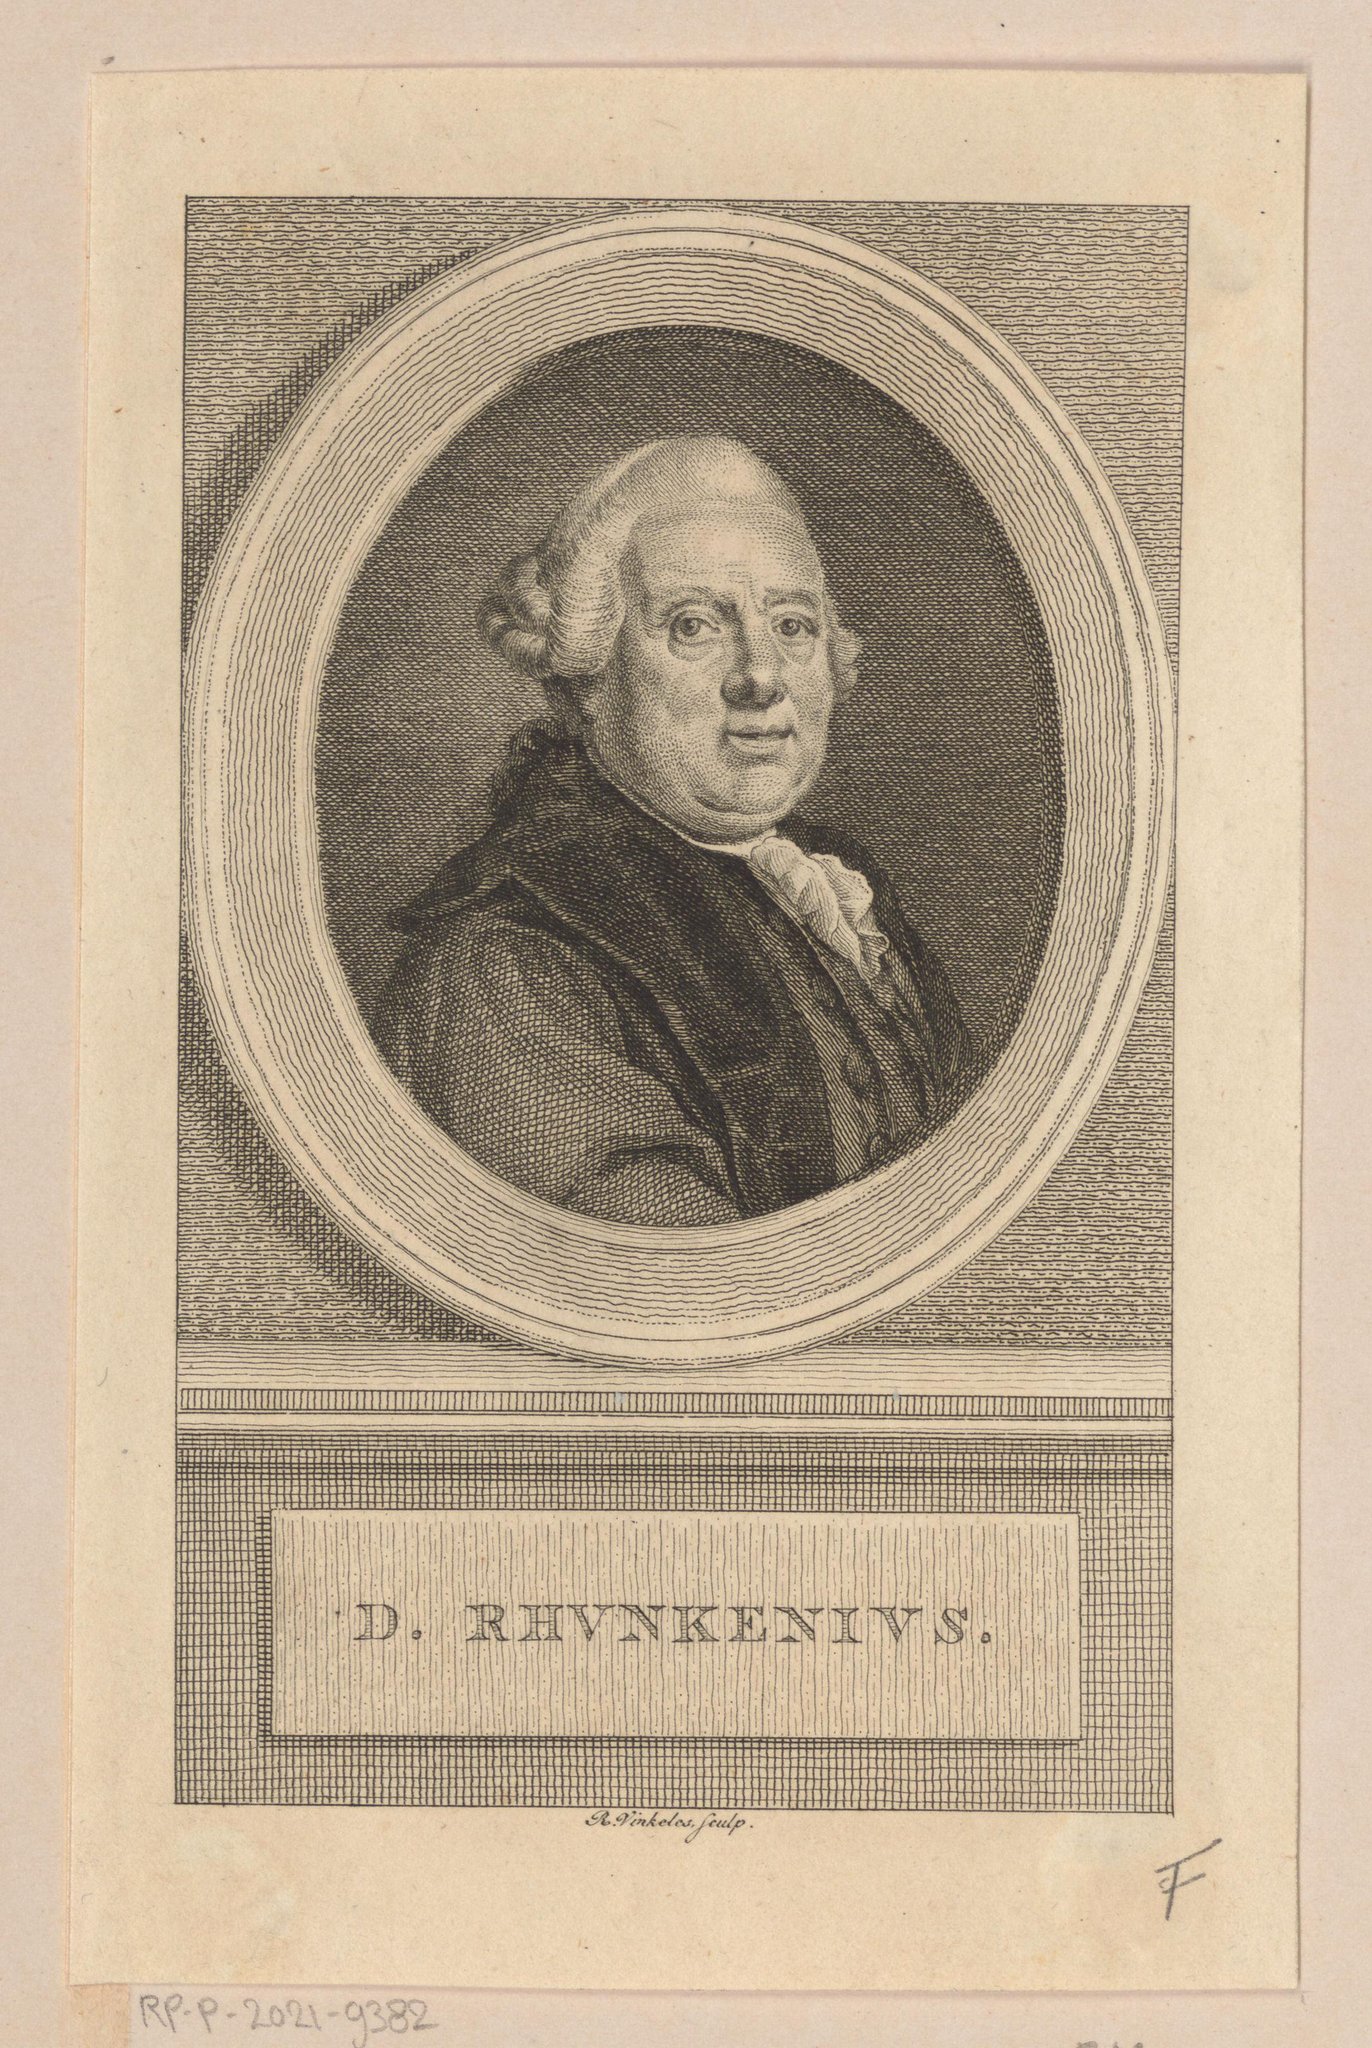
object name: print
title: Portret van David Ruhnken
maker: reinier vinkeles (i)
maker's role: draughtsman, print maker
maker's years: 1741-1816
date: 1808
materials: paper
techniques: engraving, etching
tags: leiden, historical persons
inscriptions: collector's mark: Lugt 2228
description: Prent mogelijk uit: Wagenaar, Jan. Vaderlandsche historie, (...) ten vervolge van Wagenaars Vaderlandsche historie. 43 dln. Amsterdam: Johannes Allart, 1808, dl. 40.